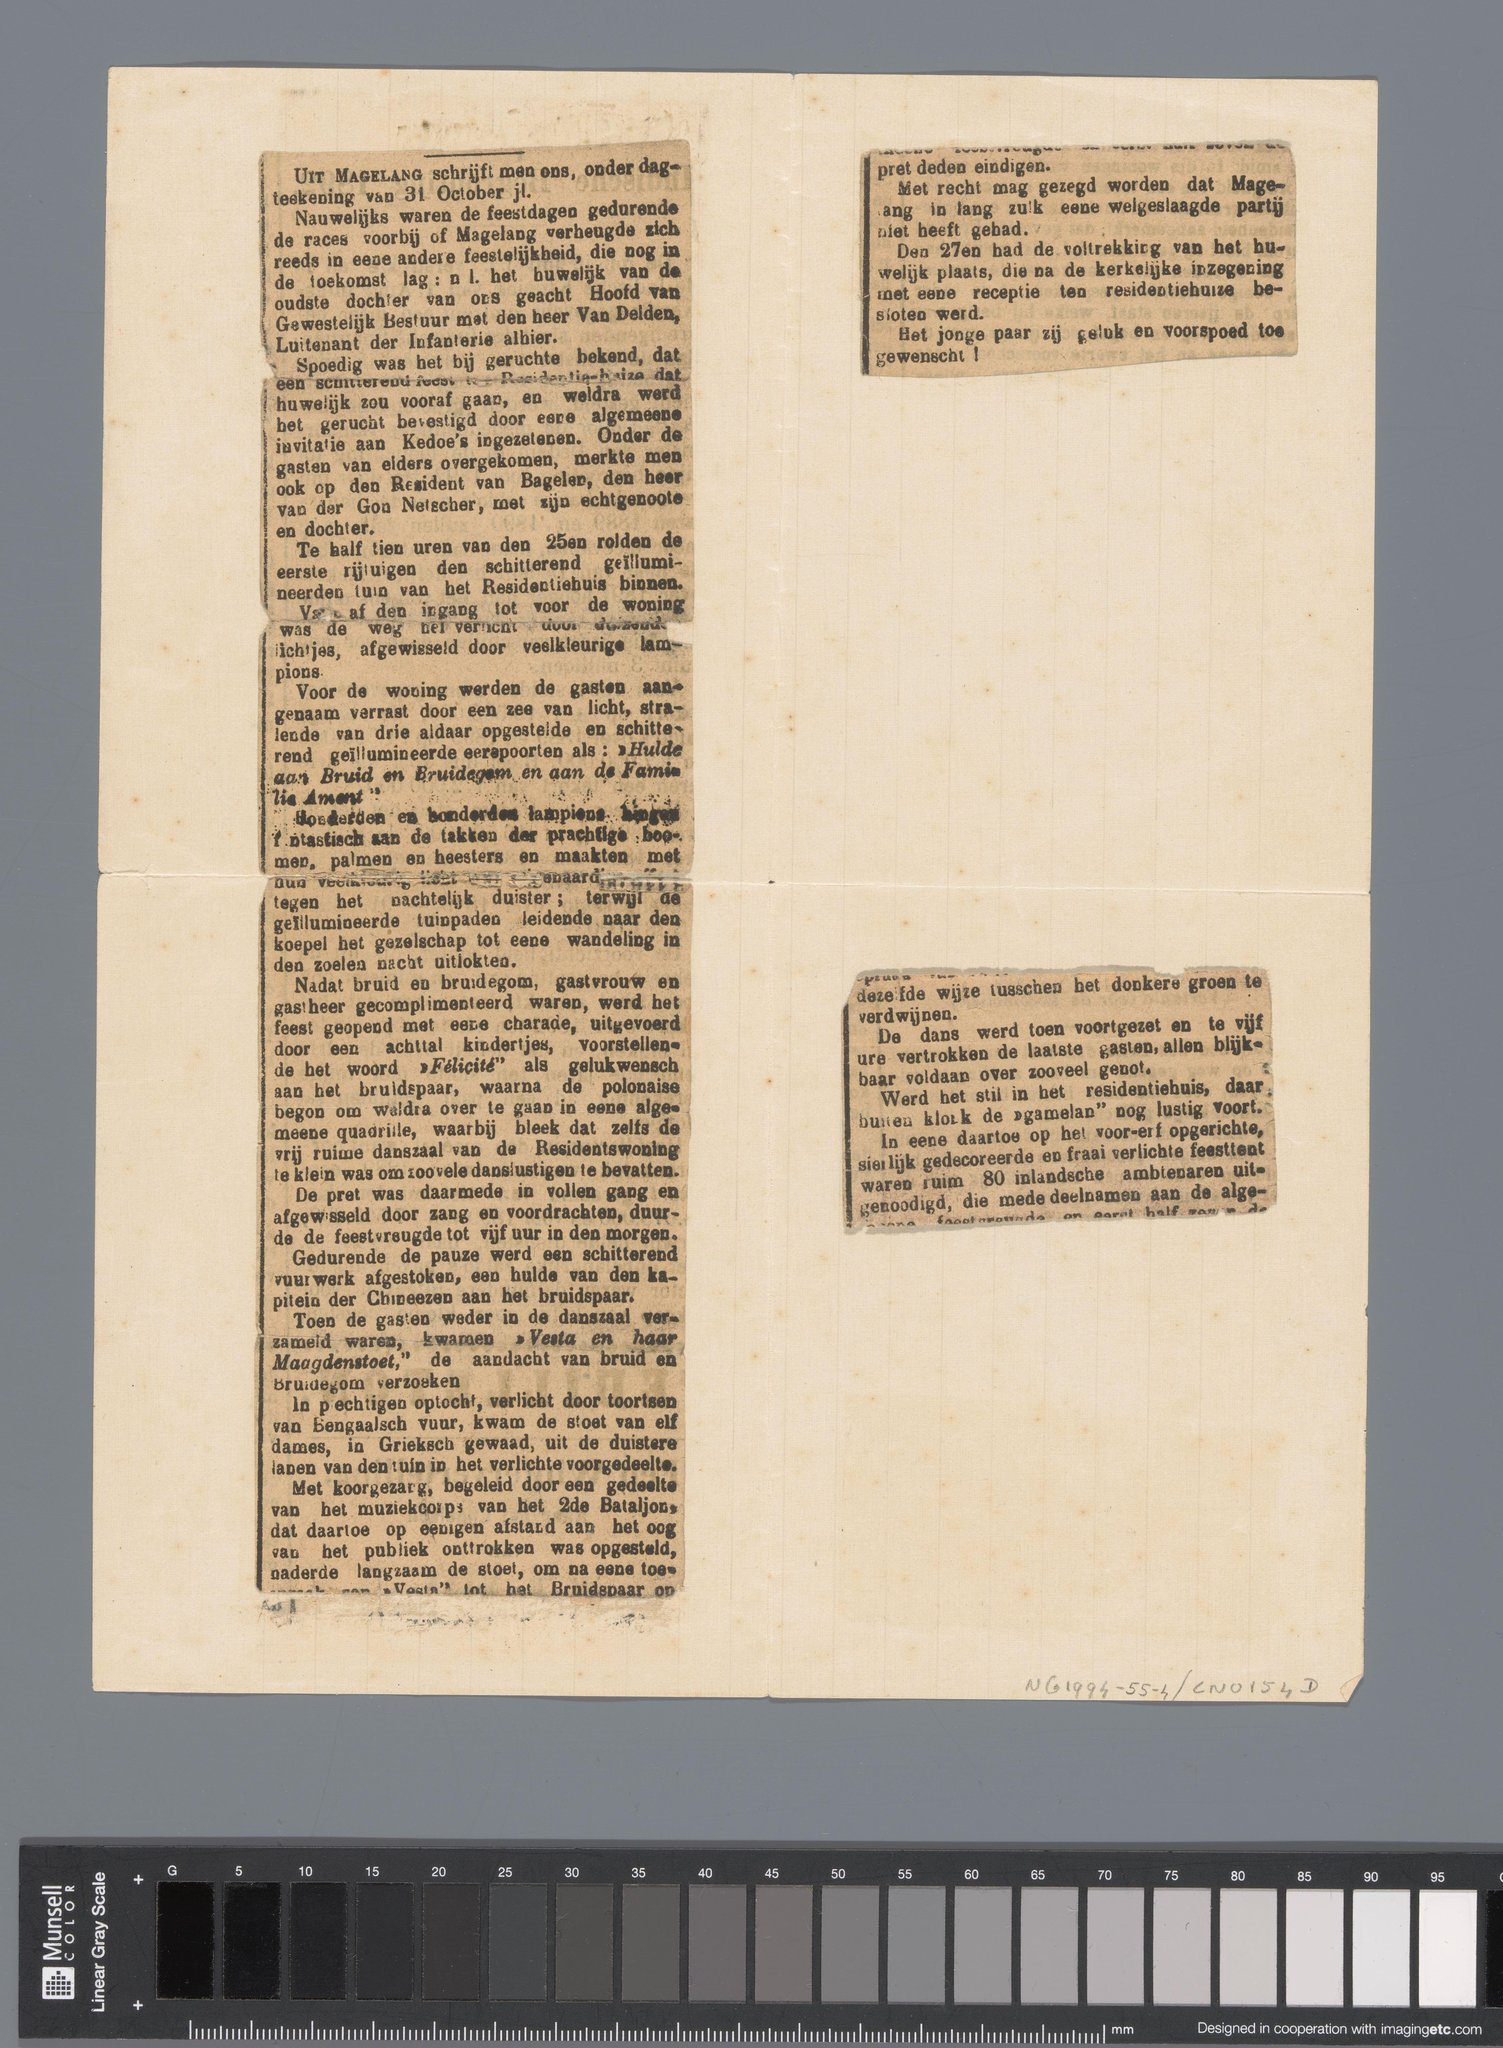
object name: newspaper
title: Krantenknipsel betreffende huwelijk Delden-Ament (1891)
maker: Anonymous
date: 1891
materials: paper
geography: dutch east indies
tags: java, the hague, justine caroline ament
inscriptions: date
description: Krantenknipsel betreffende het huwelijk tussen F.G. van Delden en J.C. Ament te Magelang op 27 oktober 1891.